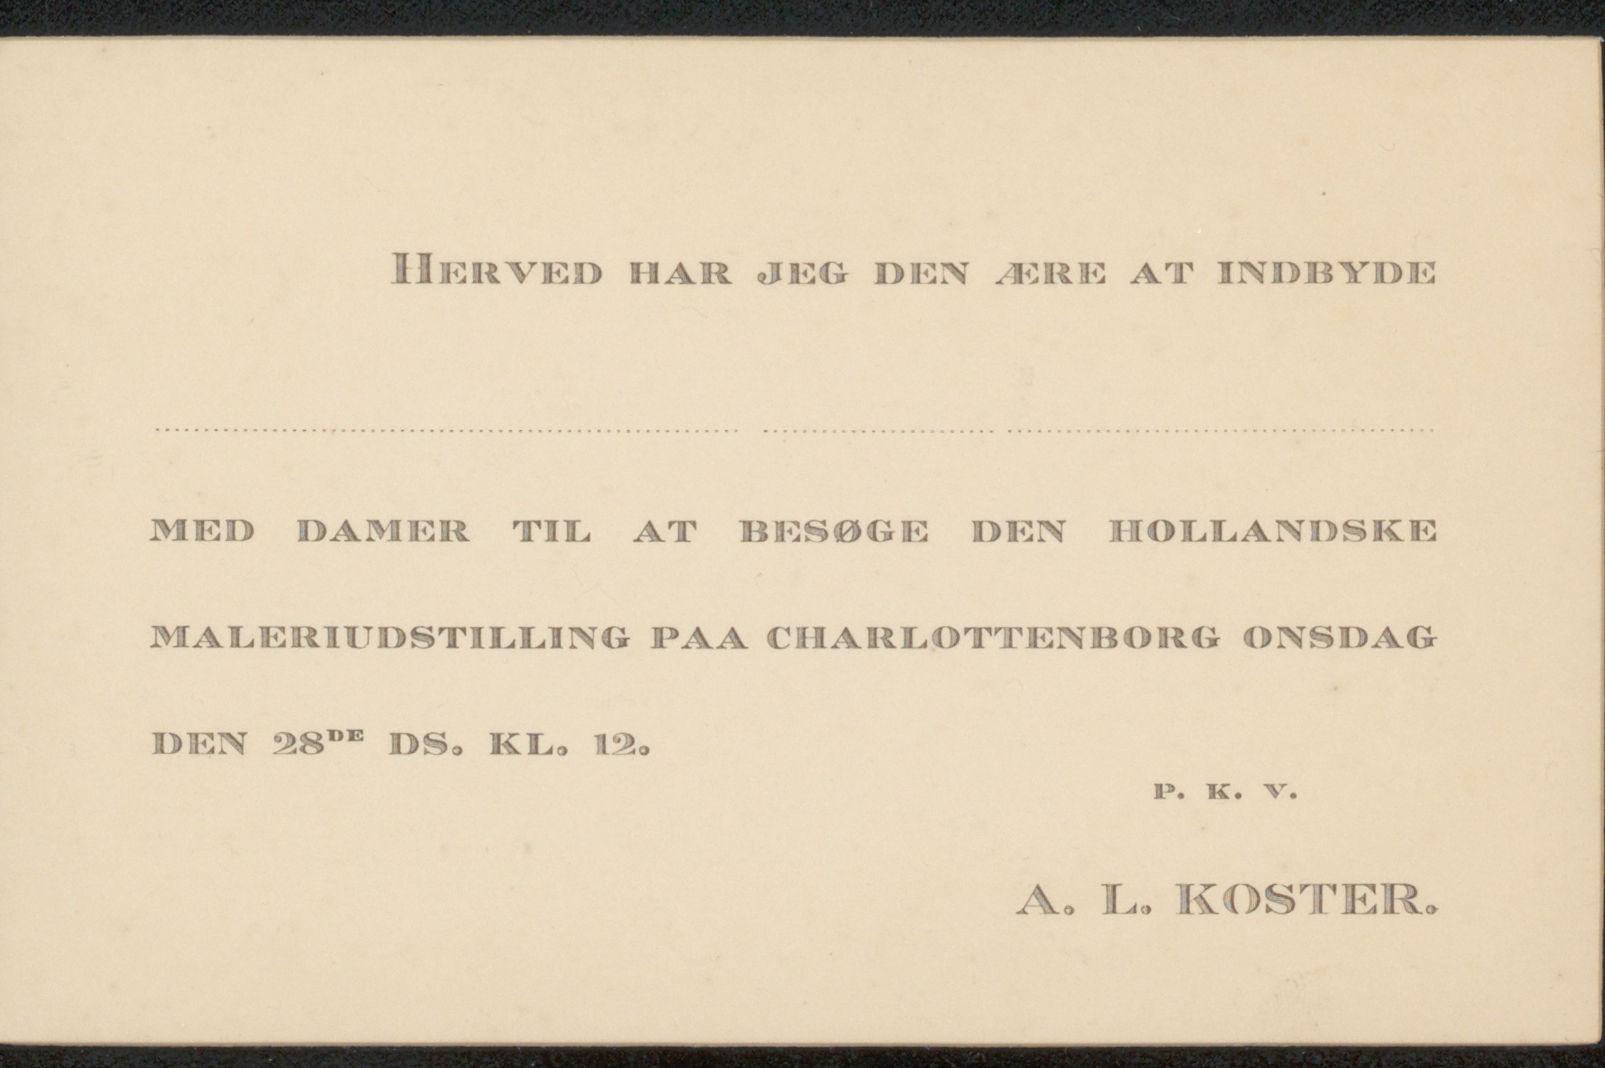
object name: invitation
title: Uitnodiging aan Philip Zilcken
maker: anton l. koster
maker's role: draughtsman, painter, print maker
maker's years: 1859-1937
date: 1867-1930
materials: cardboard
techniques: printing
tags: painter, draughtsman, philip zilcken, painting (including book-illumination, miniature-painting), exhibition ~ art, copenhagen (city)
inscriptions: collector's mark: ‘RPK’